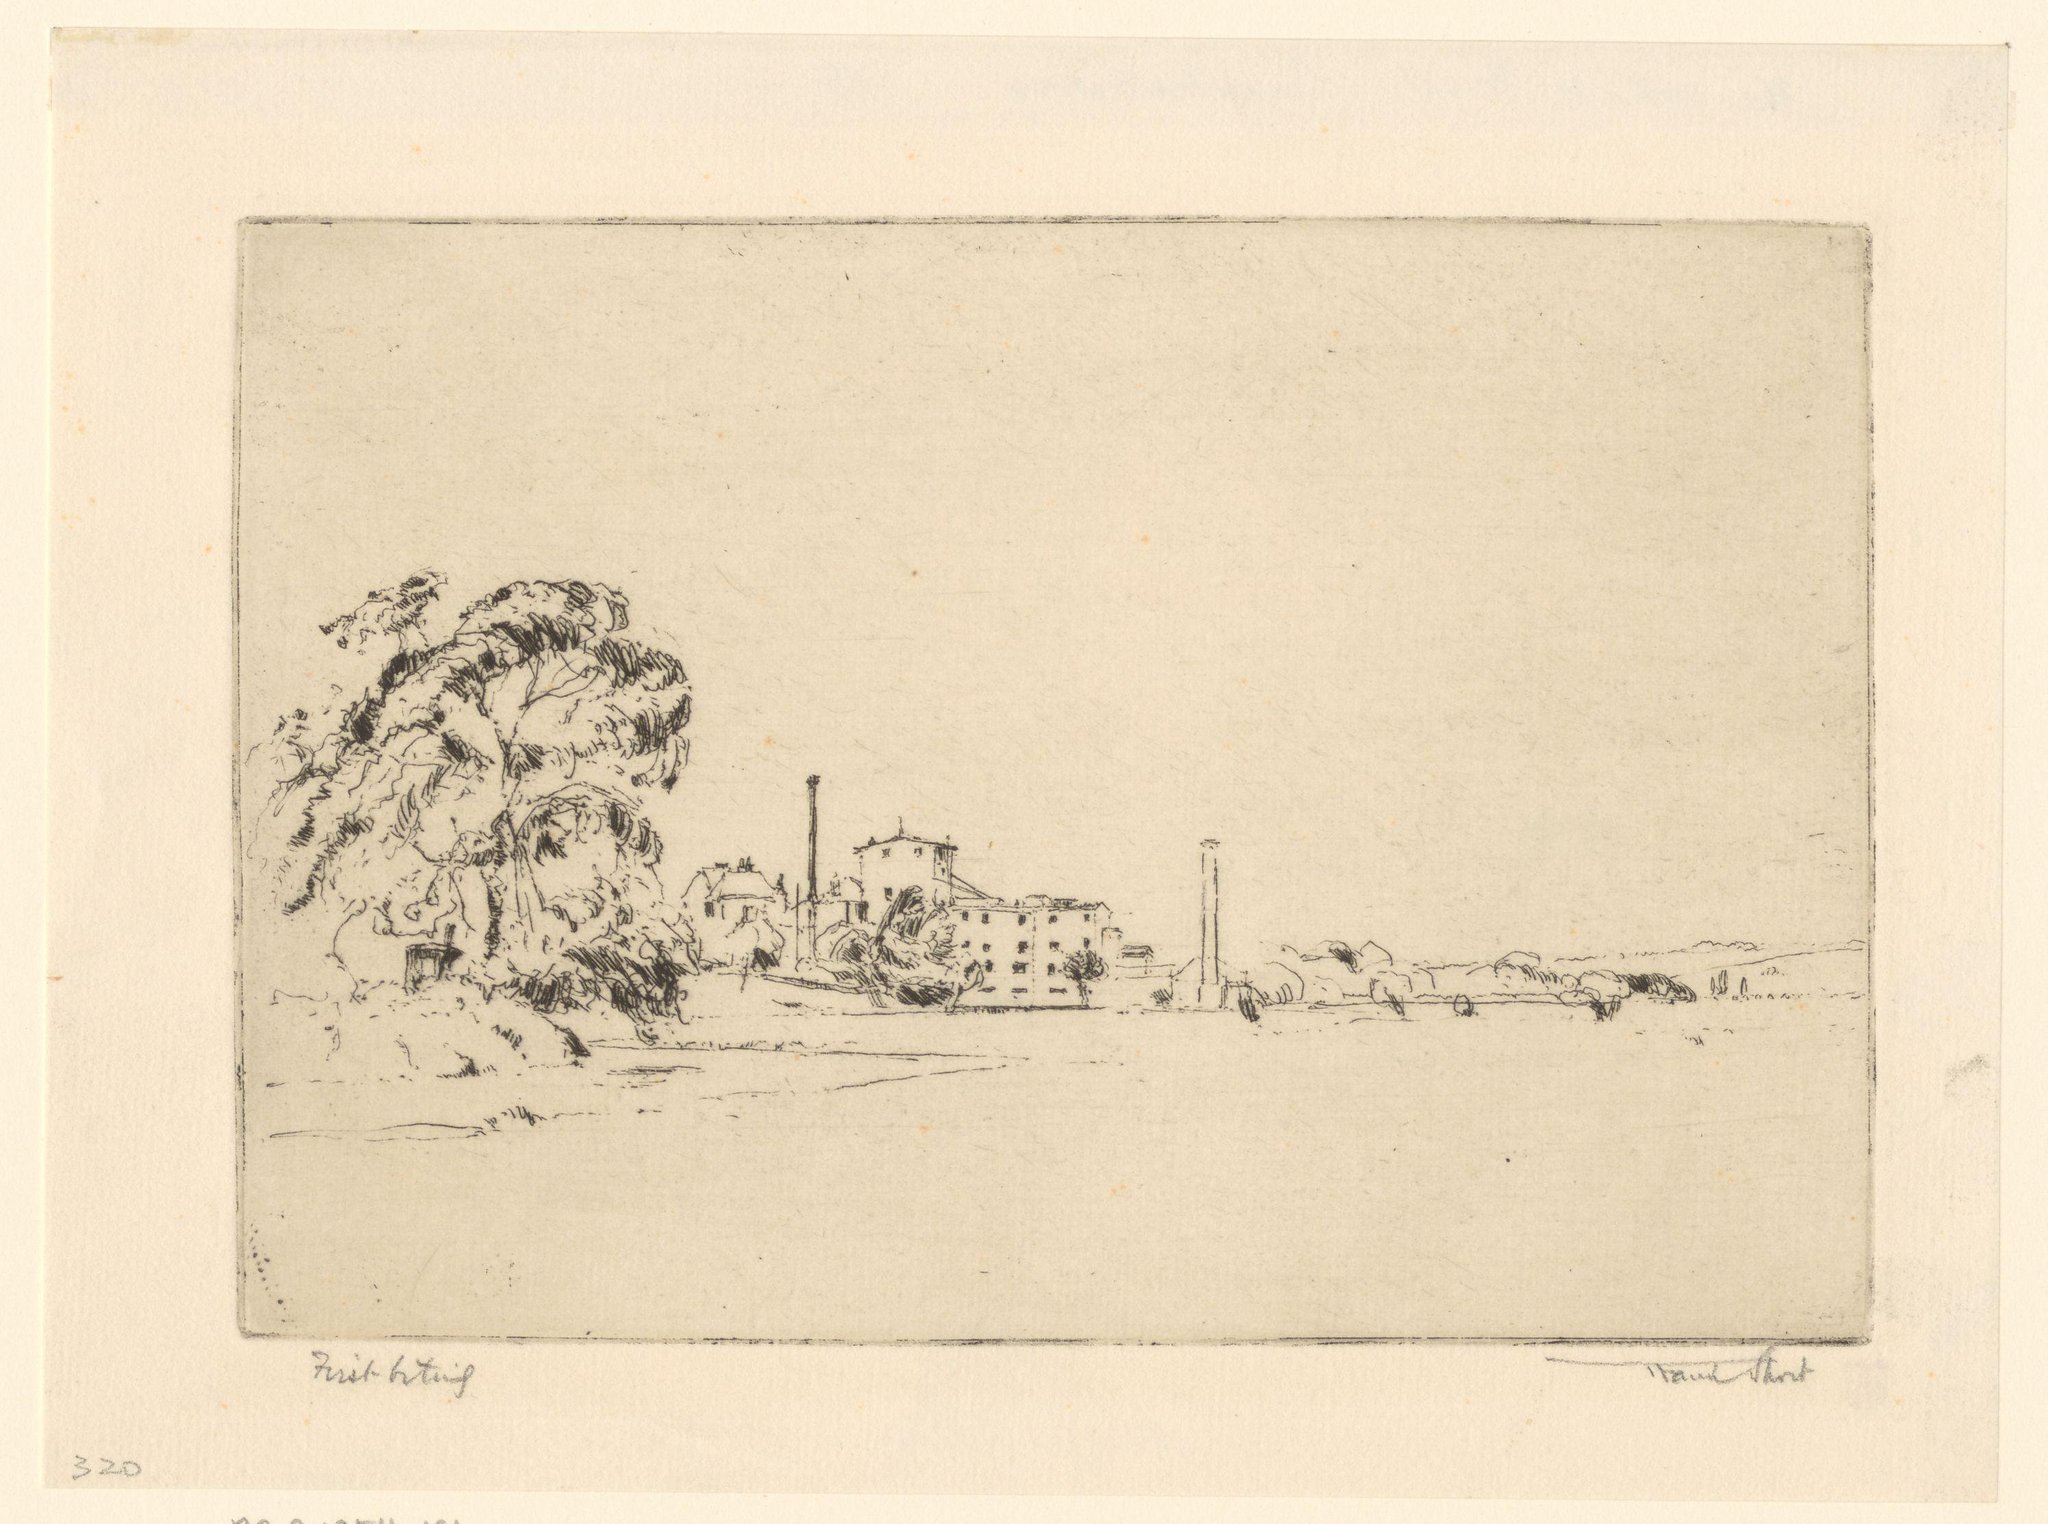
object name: print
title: The White Mill, Canterbury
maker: frank short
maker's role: print maker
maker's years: 1857-1945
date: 1930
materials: paper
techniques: etching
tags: smoke-stack, watermill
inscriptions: signature: ‘Frank Short’, collector's mark: Lugt 2228, collector's mark: Lugt 2760